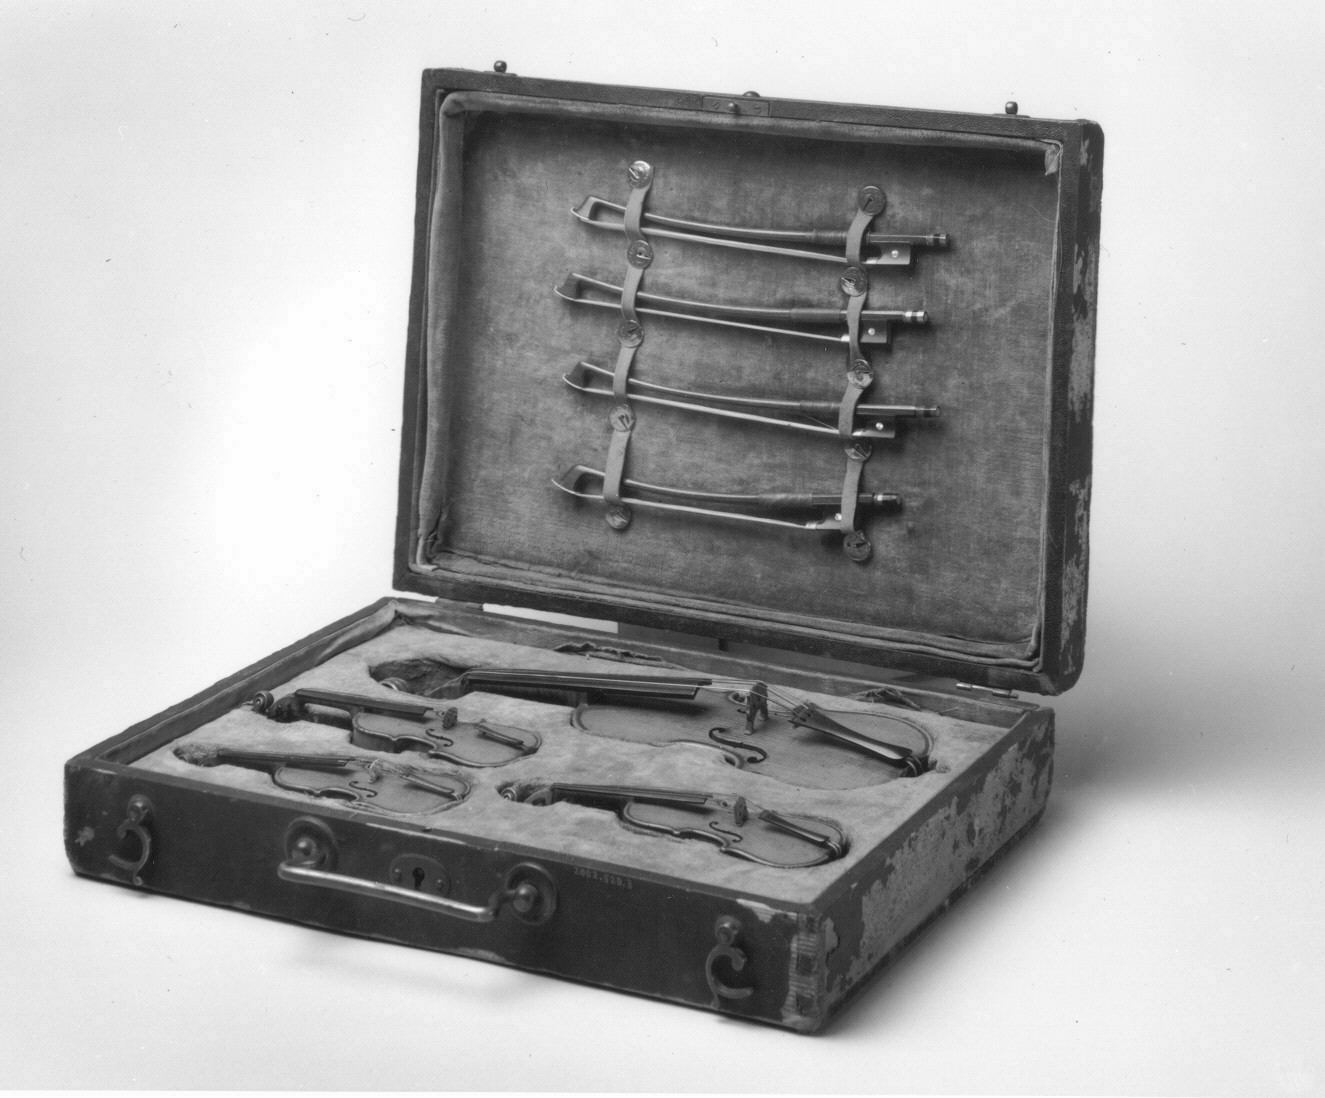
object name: miniature string quartet case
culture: european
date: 1801-1833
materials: leather, wood